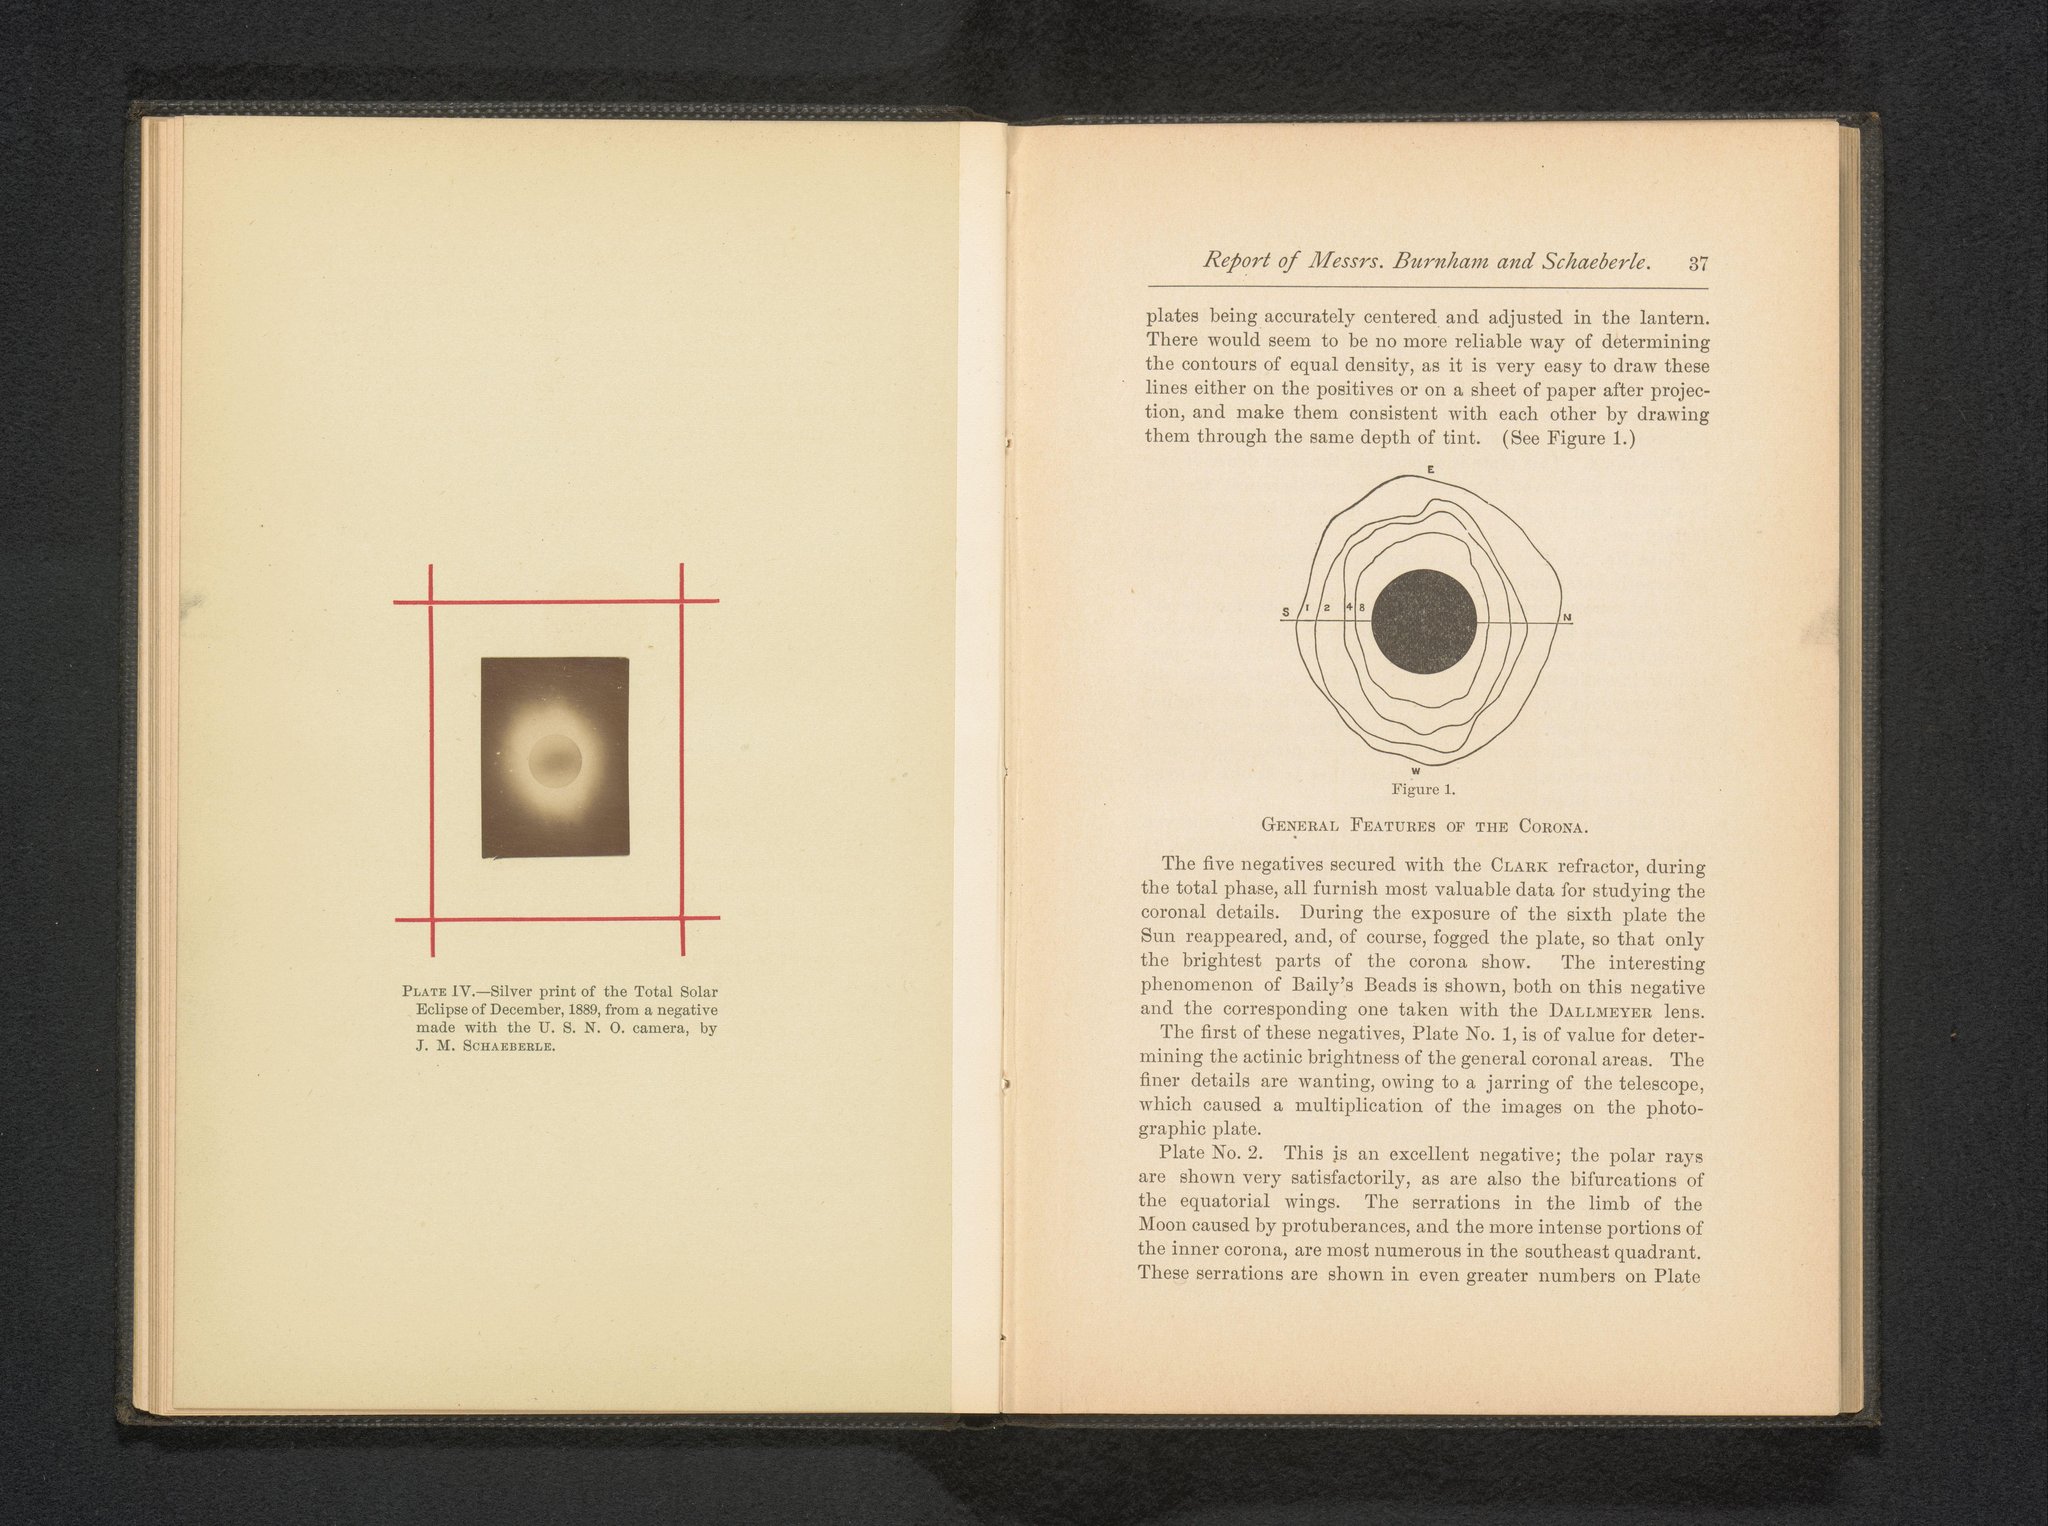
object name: photograph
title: Zonsverduistering op 22 december 1889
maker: john martin schaeberle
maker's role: astronoom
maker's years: 1853-1924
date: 1889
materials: photographic support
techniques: albumen print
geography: lick observatory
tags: total solar eclipse with corona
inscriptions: inscription: ‘Plate IV. - Silver print of the Total Solar/ Eclipse of December, 1889, from a negative/ made with the U. S. N. O. camera, by/ J. M. Schaeberle.’